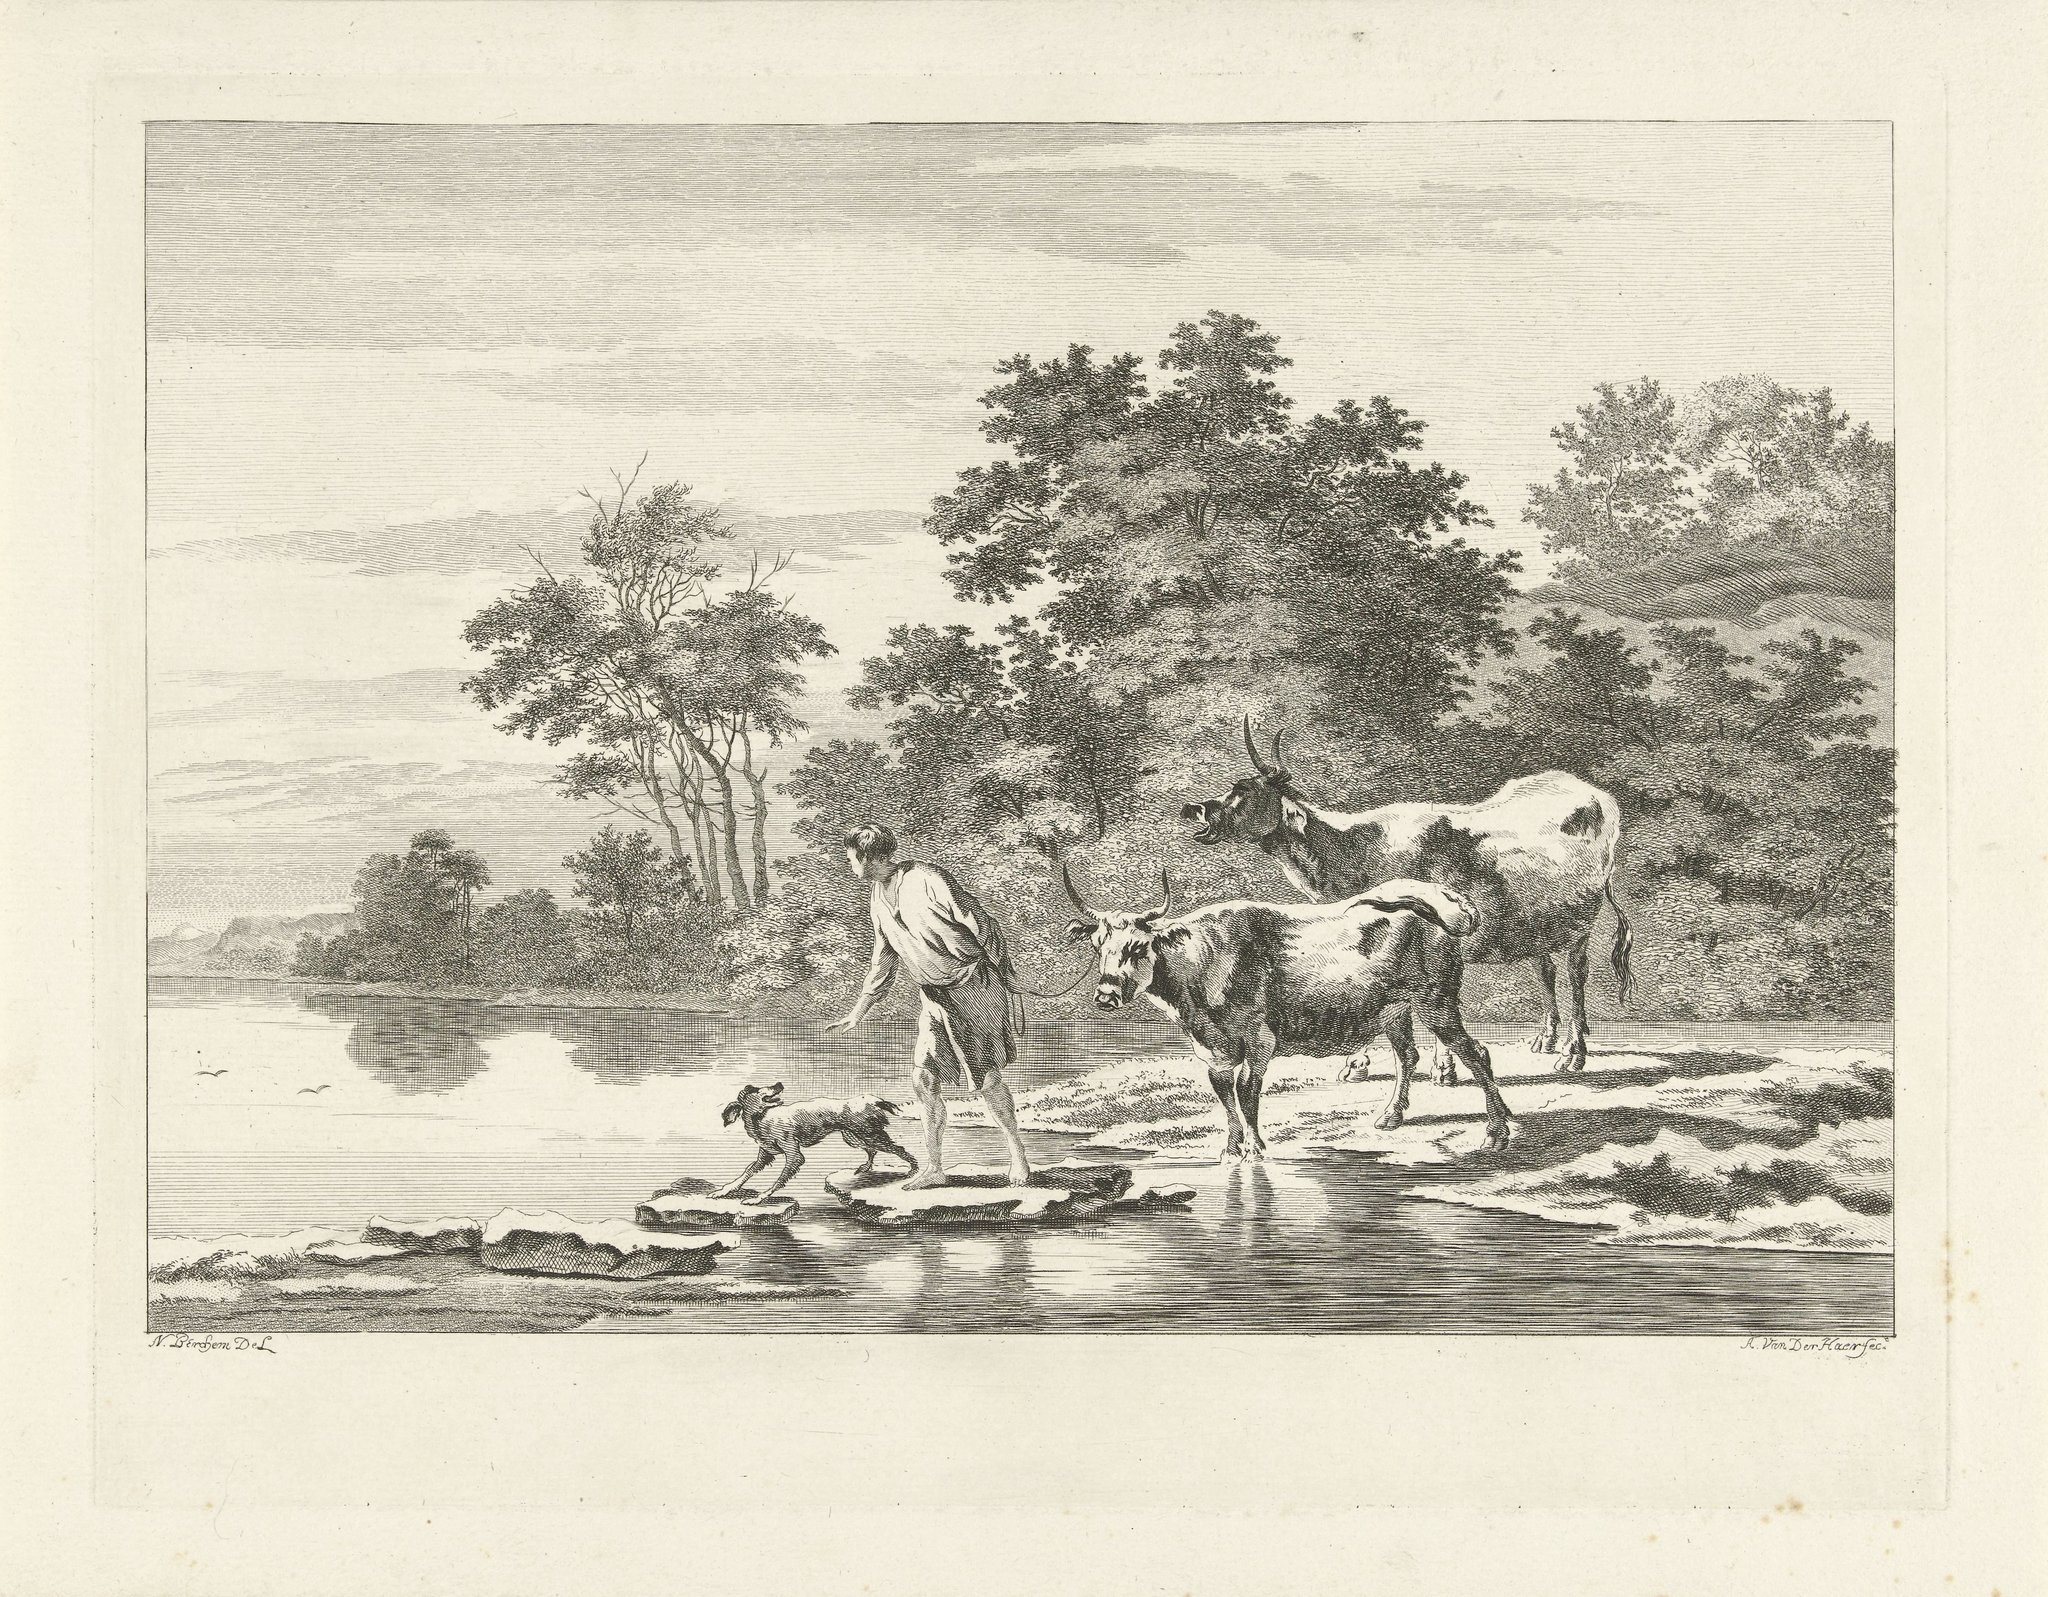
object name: print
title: Man met twee ossen en een hond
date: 1745-1785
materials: paper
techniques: etching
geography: northern netherlands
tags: cow, landscapes with waters, waterscapes, seascapes (in the temperate zone) (+ landscape with figures, staffage), dog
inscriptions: collector's mark: Lugt 240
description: Een man saat op een platte steen in een rivier om over te steken met twee ossen, voor zijn voeten loopt een hond.